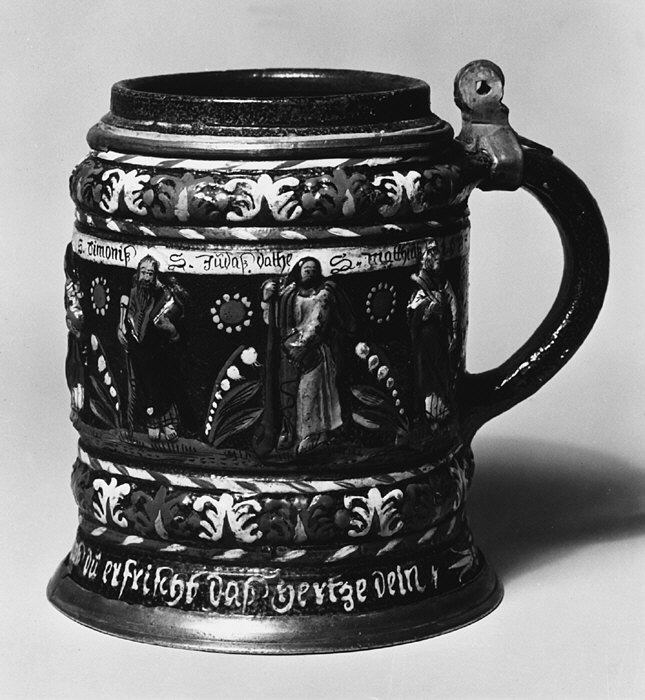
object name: tankard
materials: stoneware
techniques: salt glaze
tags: human figures